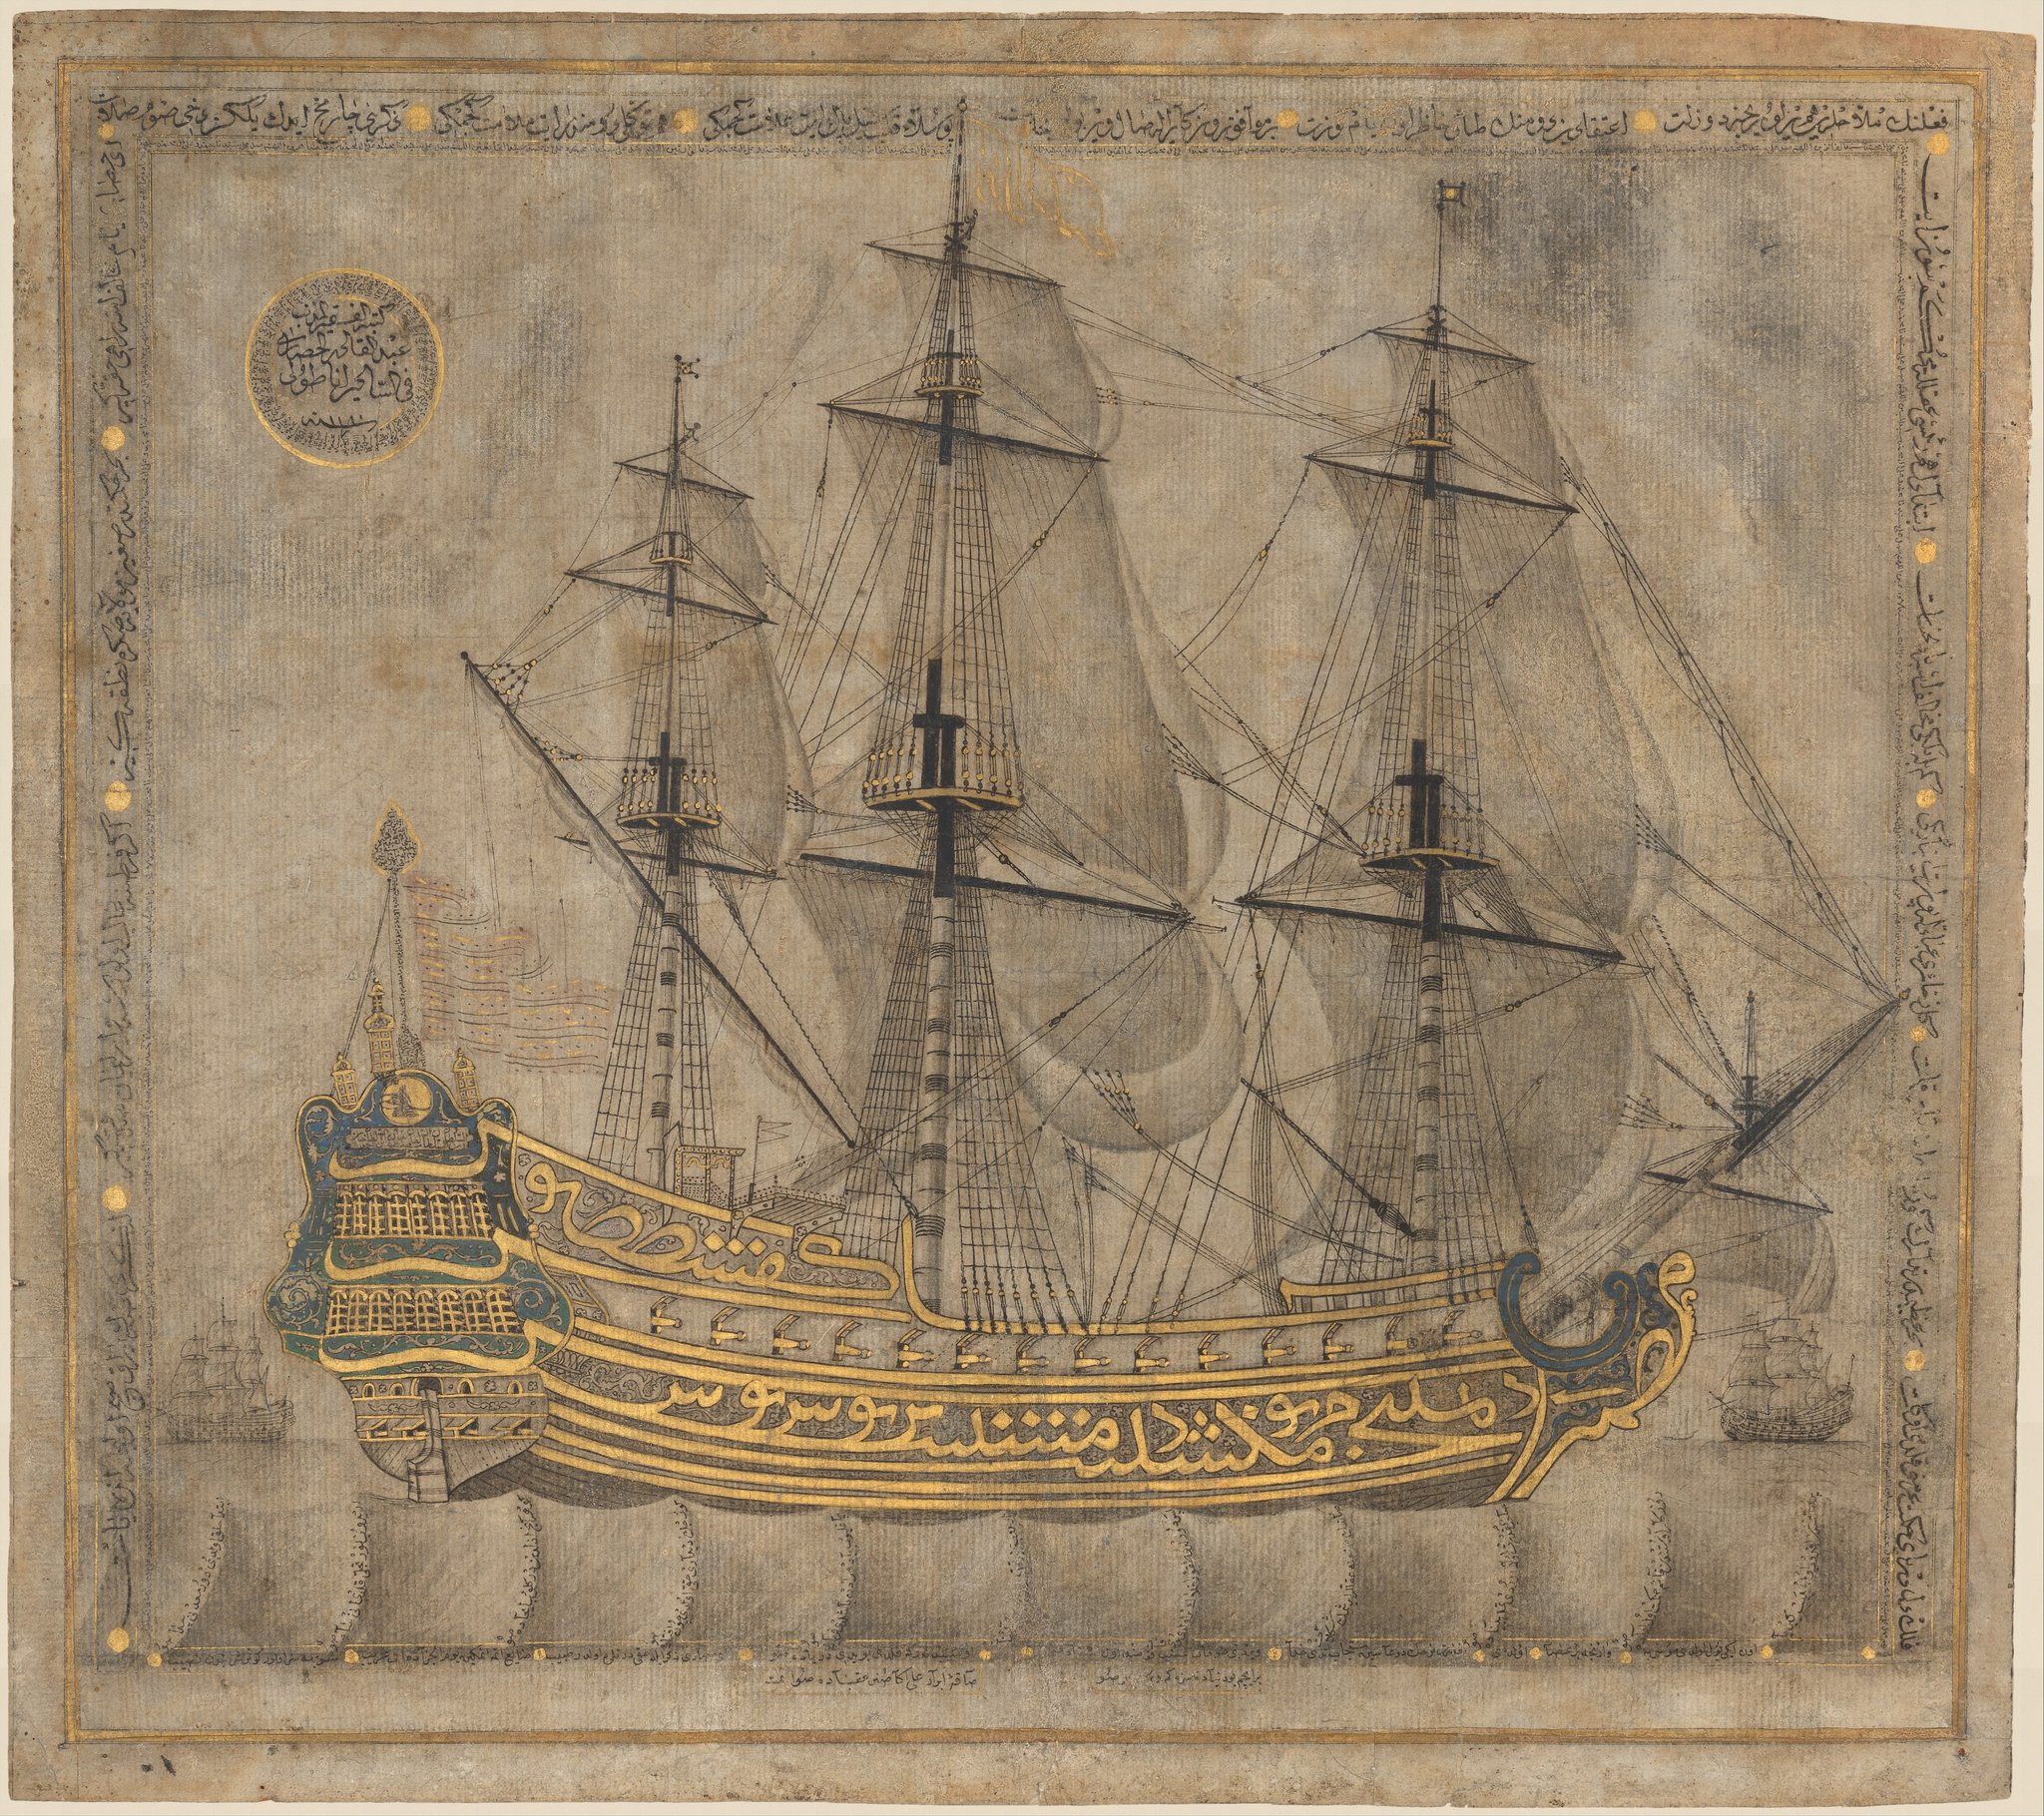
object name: illustrated single work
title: Calligraphic Galleon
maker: 'abd al-qadir hisari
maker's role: calligrapher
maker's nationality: turkish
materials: gold, ink, paper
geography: turkey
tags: ships,calligraphy